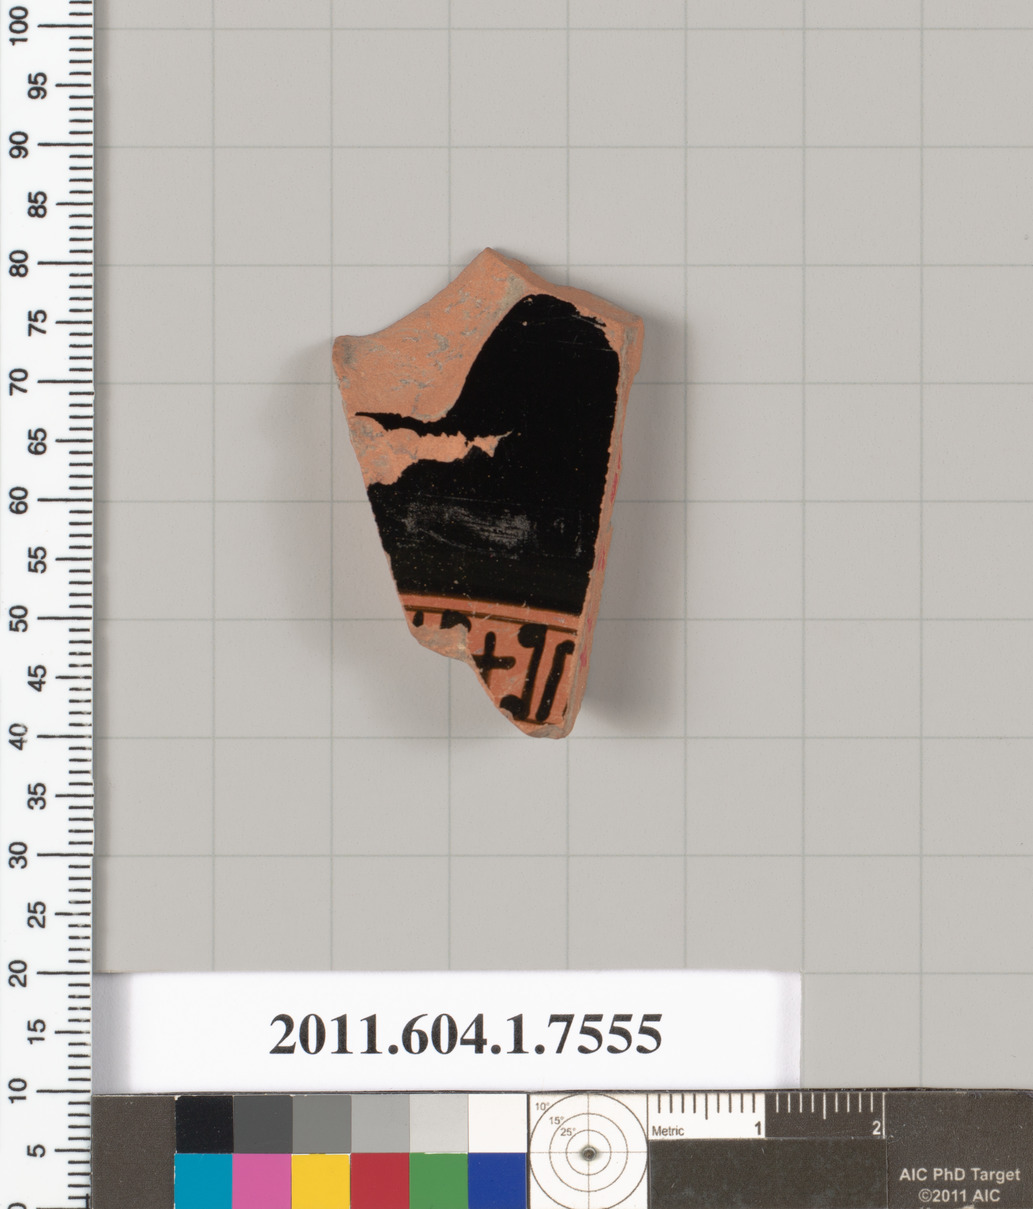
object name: kylix fragment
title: Terracotta fragment of a kylix (drinking cup)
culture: greek, attic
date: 460-450 BCE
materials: terracotta